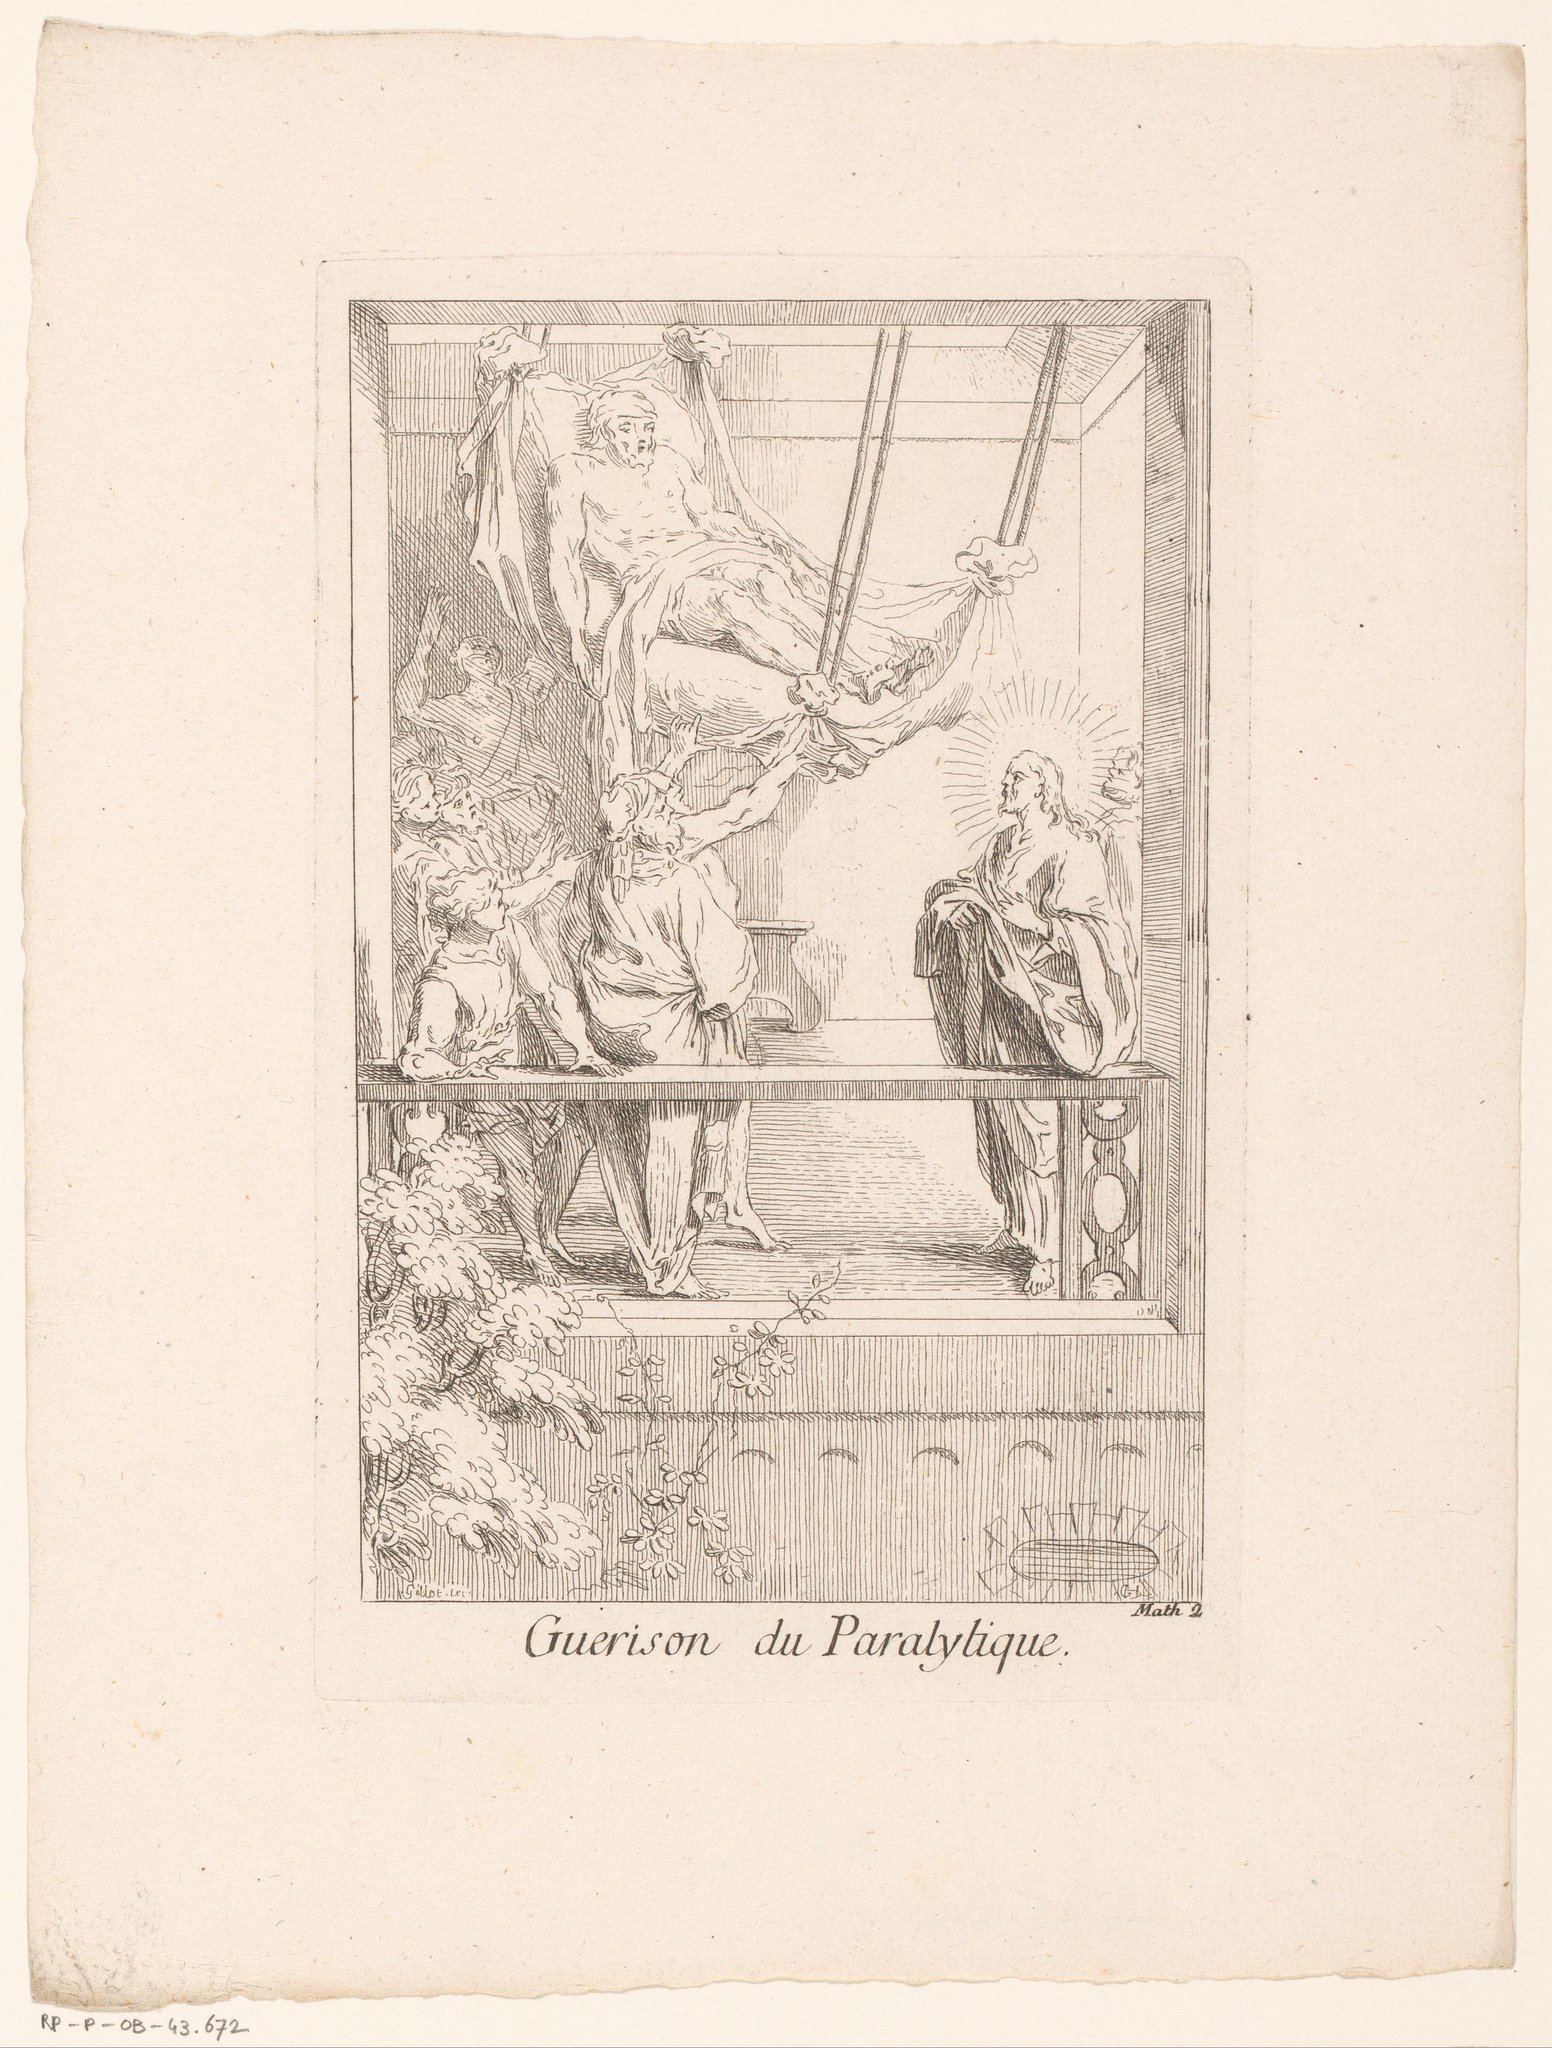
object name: print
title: Leven en passie van Christus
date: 1705-1732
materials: paper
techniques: etching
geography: paris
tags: a paralytic is let down through the roof of the house where christ is preaching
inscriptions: collector's mark: Lugt 2228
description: Maakt deel uit van een serie met zestig prenten met als thema het leven van Christus.